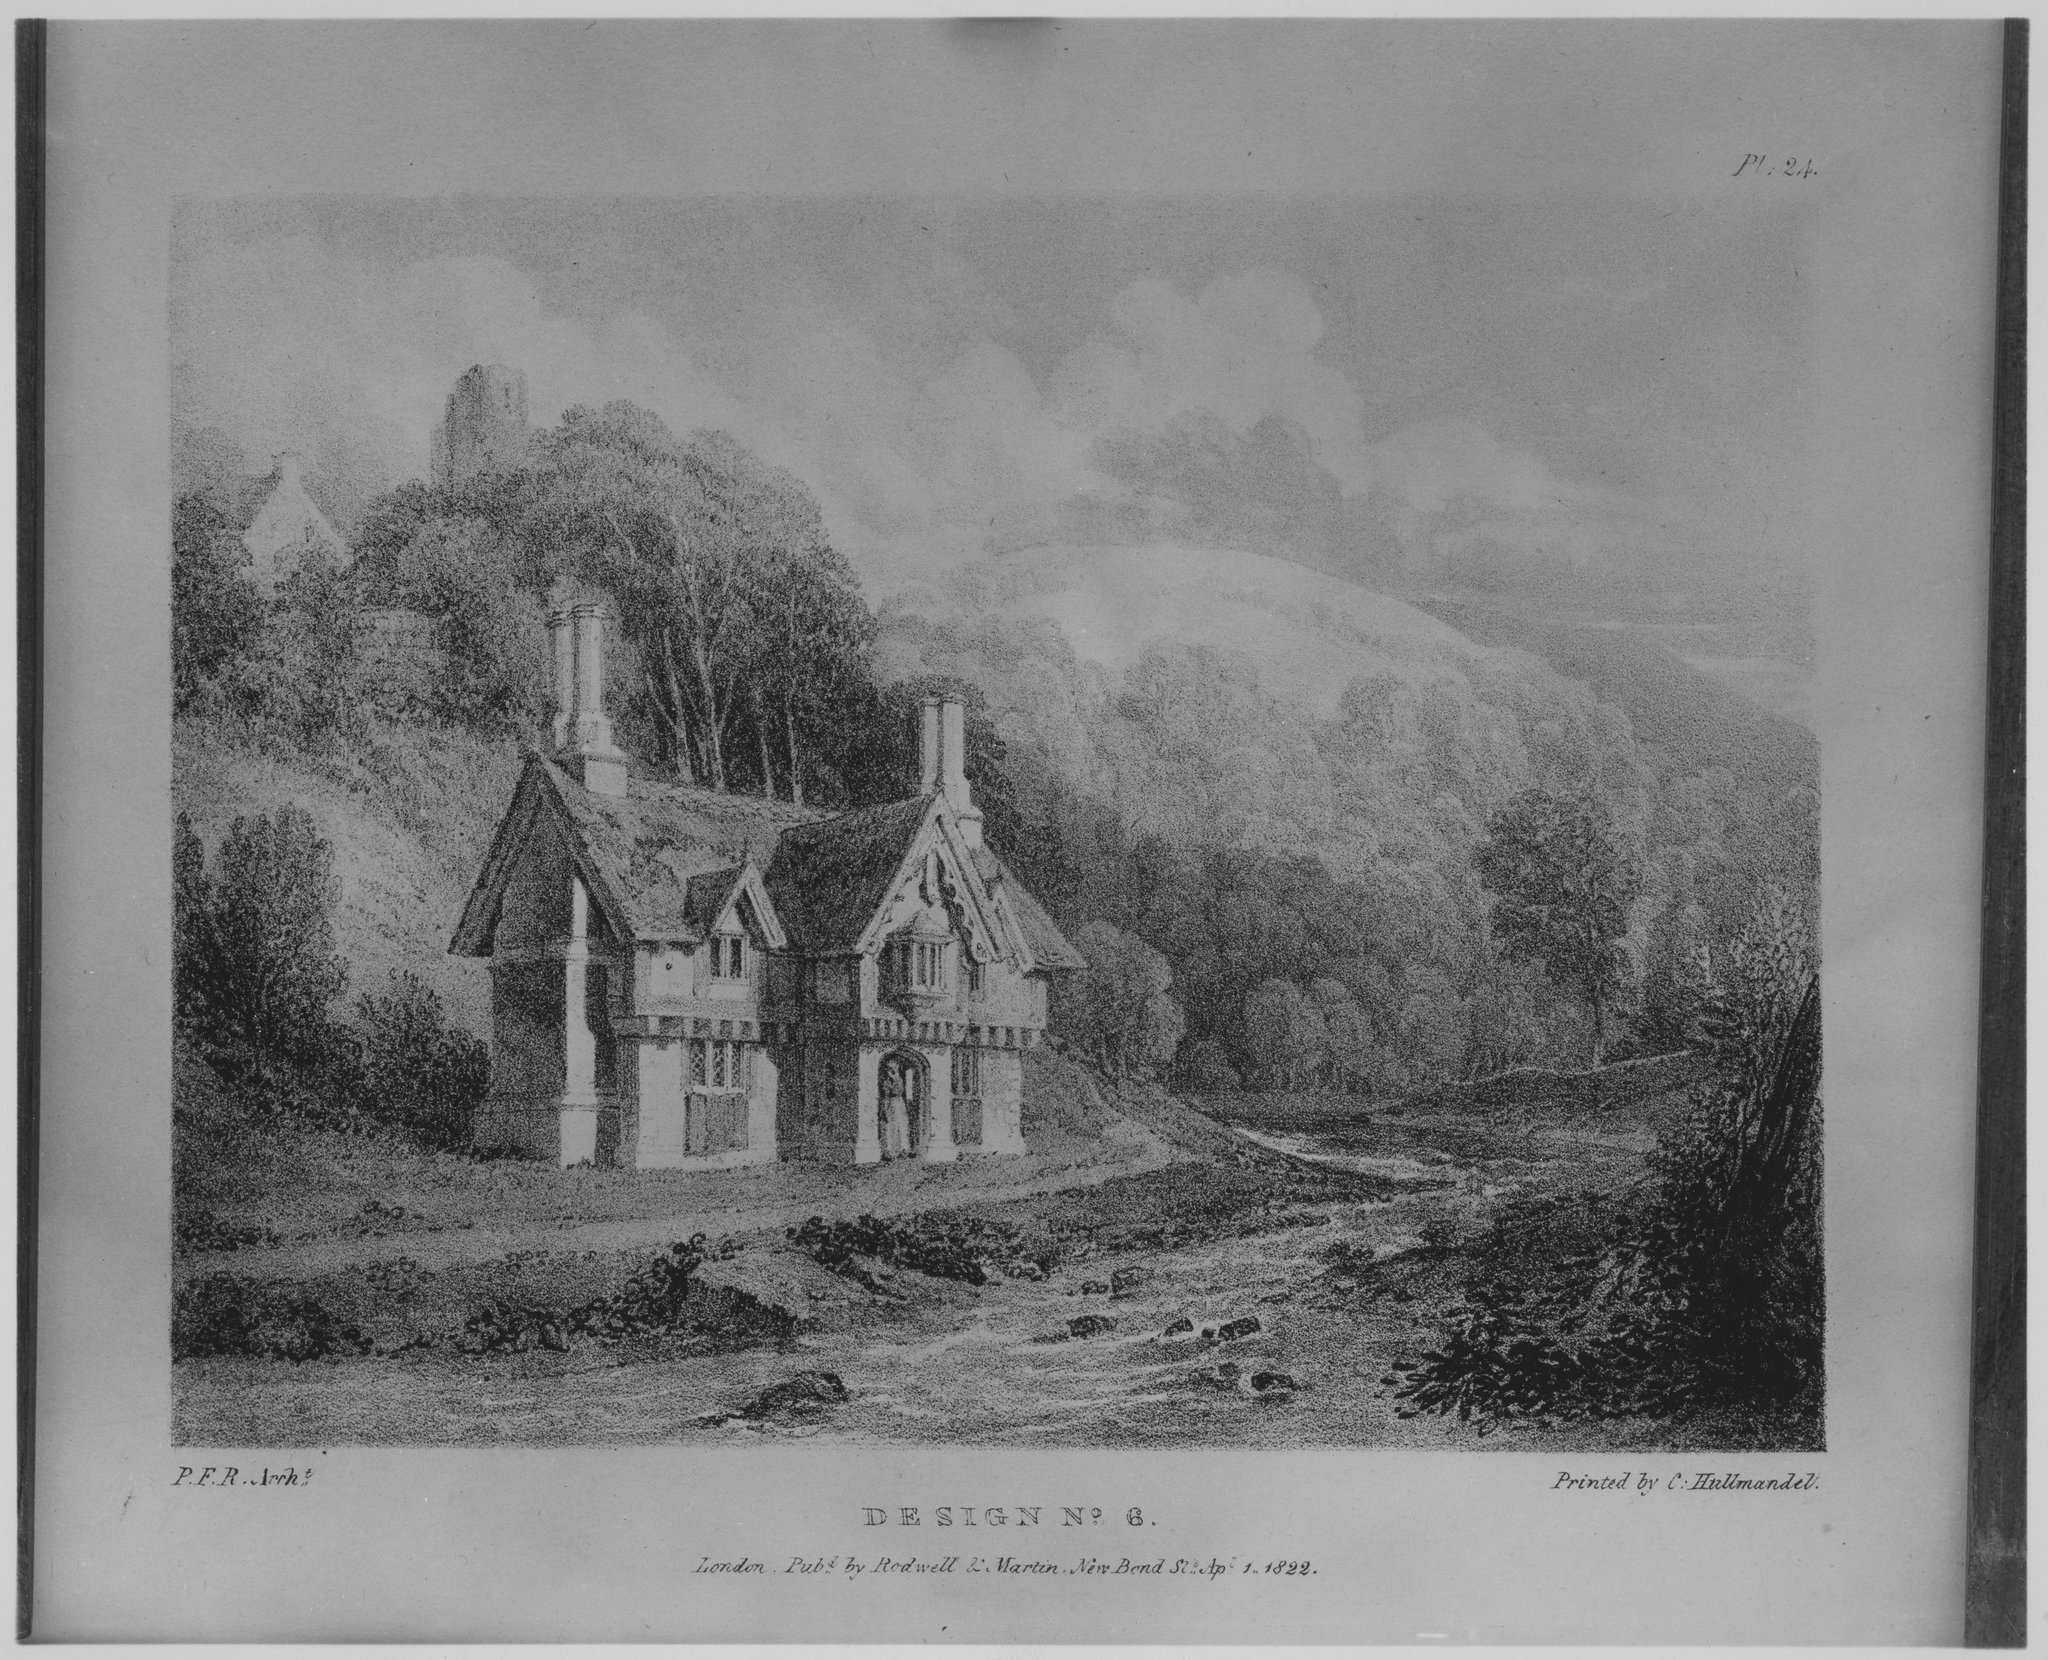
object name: book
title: Rural Architecture, or a Series of Designs for Ornamental Cottages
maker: peter frederick robinson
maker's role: designer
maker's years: 1776-1858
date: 1823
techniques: lithograph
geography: london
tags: houses